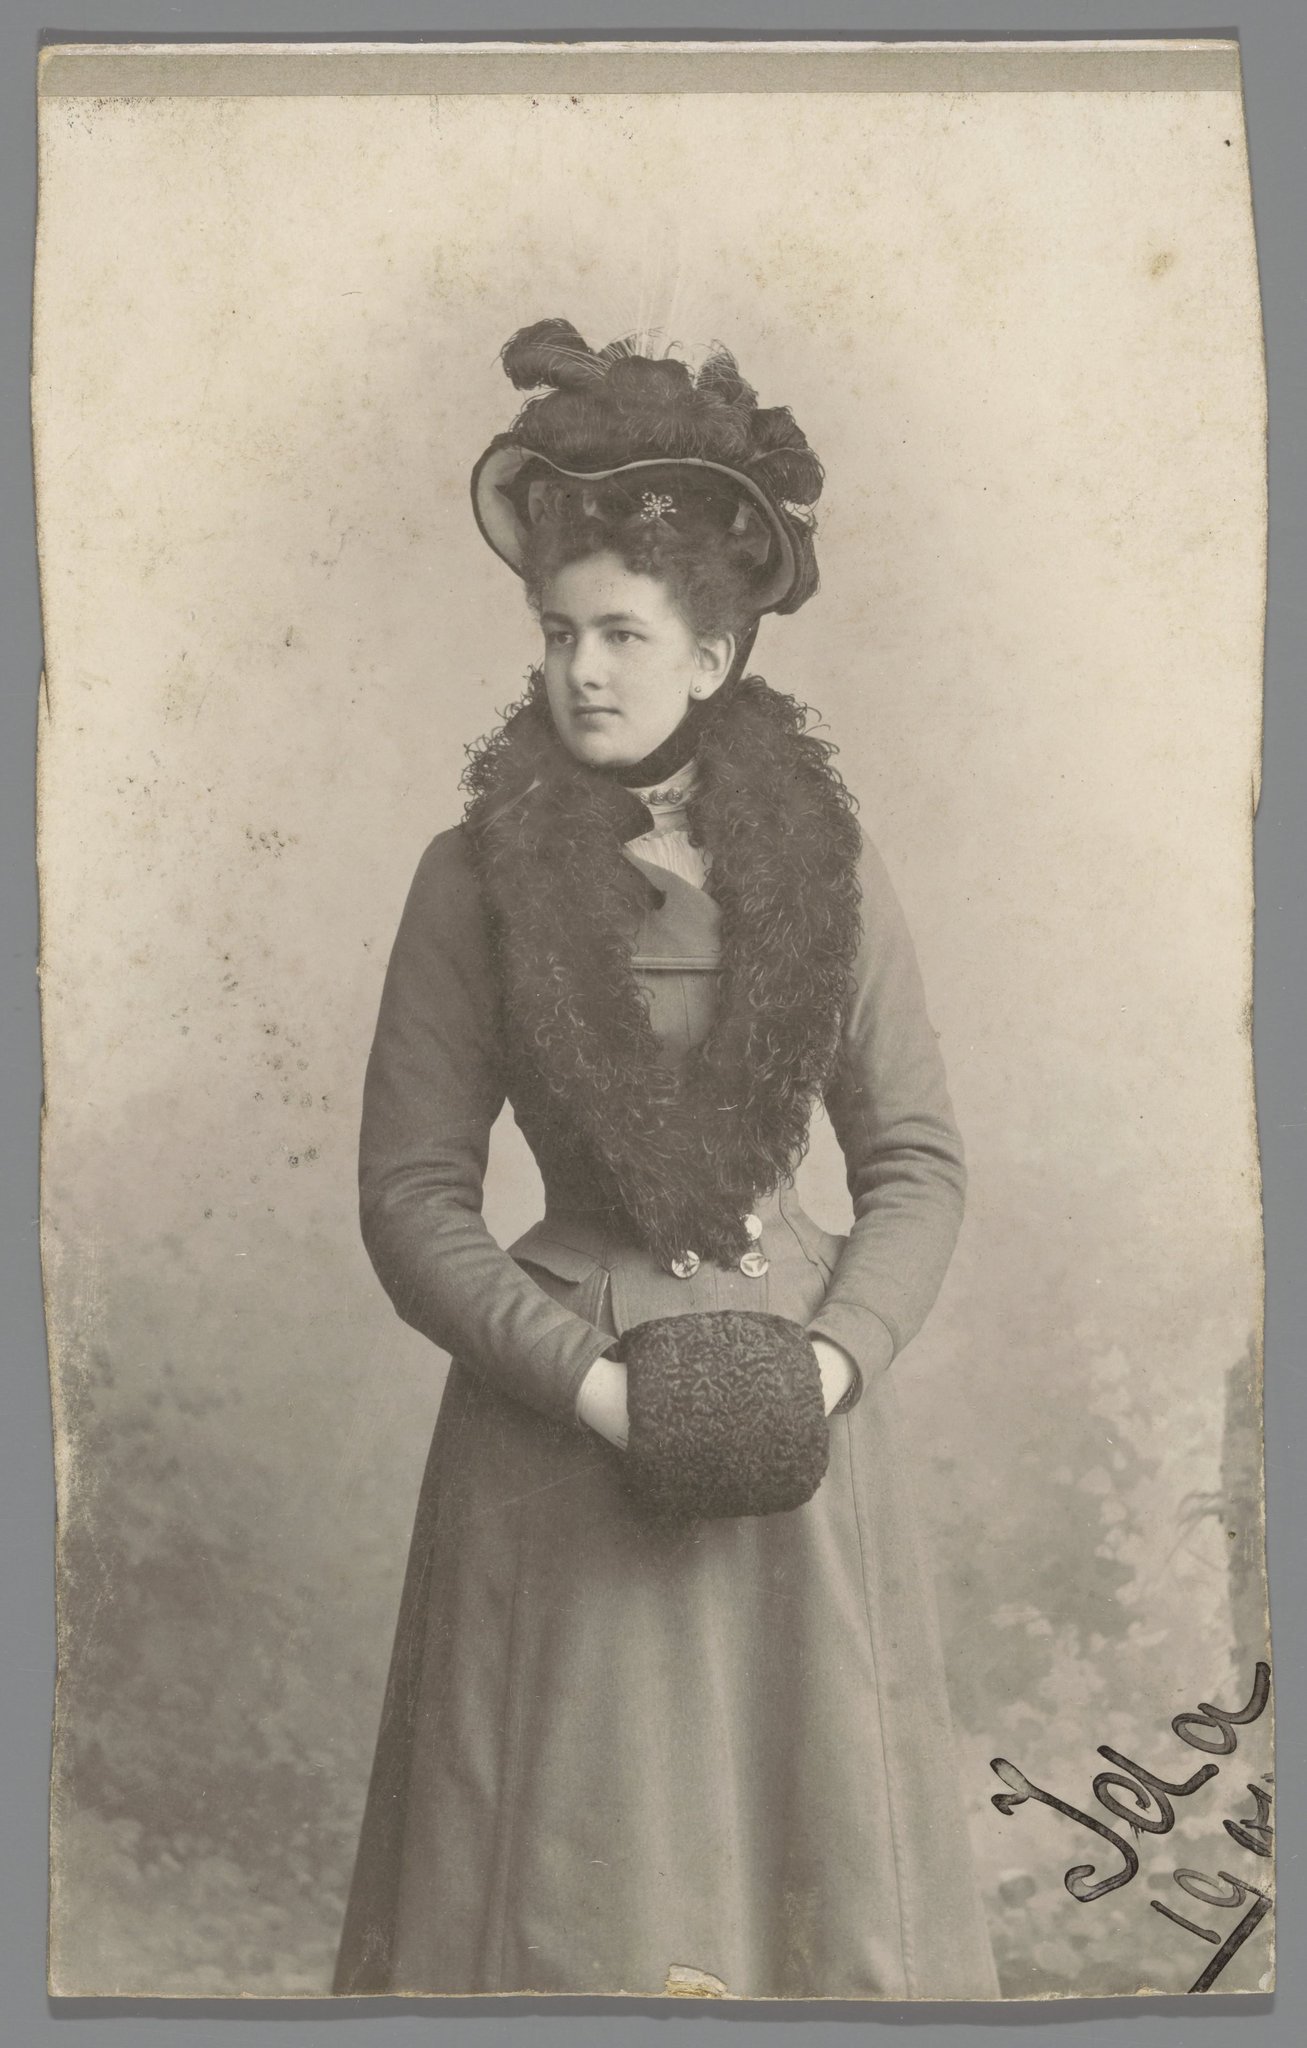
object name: photograph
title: Portret van Ida van Braam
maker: Anonymous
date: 1900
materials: photographic support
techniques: albumen print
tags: historical persons - bb - woman